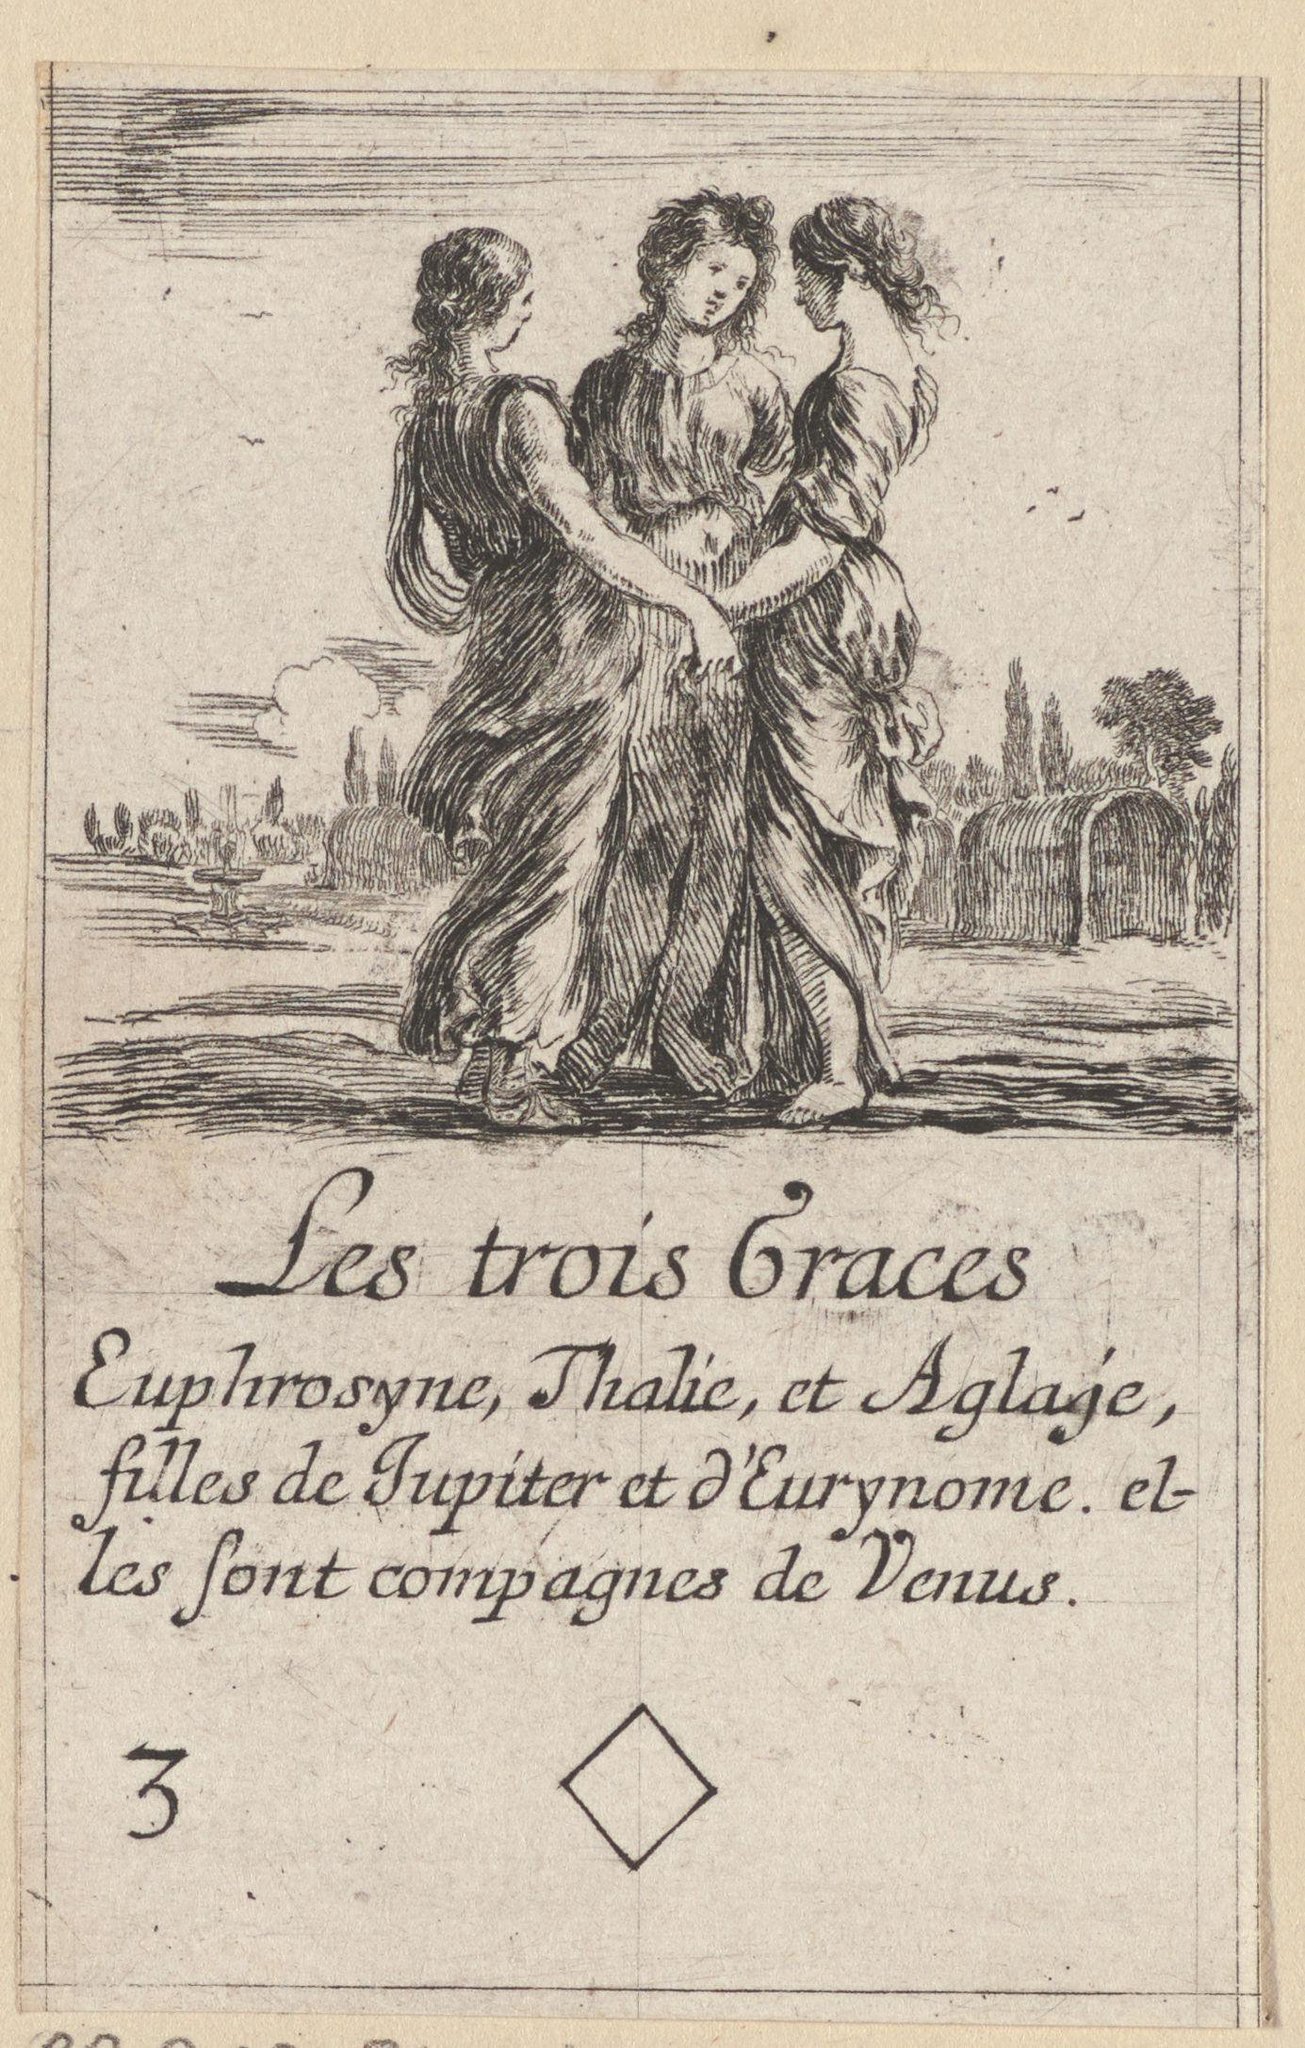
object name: print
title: Kaartspel met mythologische voorstellingen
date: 1620-1664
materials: paper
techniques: etching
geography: paris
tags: graces (charites), generally three in number; 'gratie' (ripa)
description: Deze prent maakt deel uit van een kaartspel met 52 kaarten met voorstellingen uit de Metamorfosen van Ovidius. De serie is uitgedacht door Jean Desmarests de Saint-Sorlin in opdracht van Kardinaal Mazarin. Het kaartspel werd gemaakt voor de jonge Lodewijk XIV, samen met het Jeu des Reynes Renommées, Jeu de la Géographie en Jeu des Rois de France.